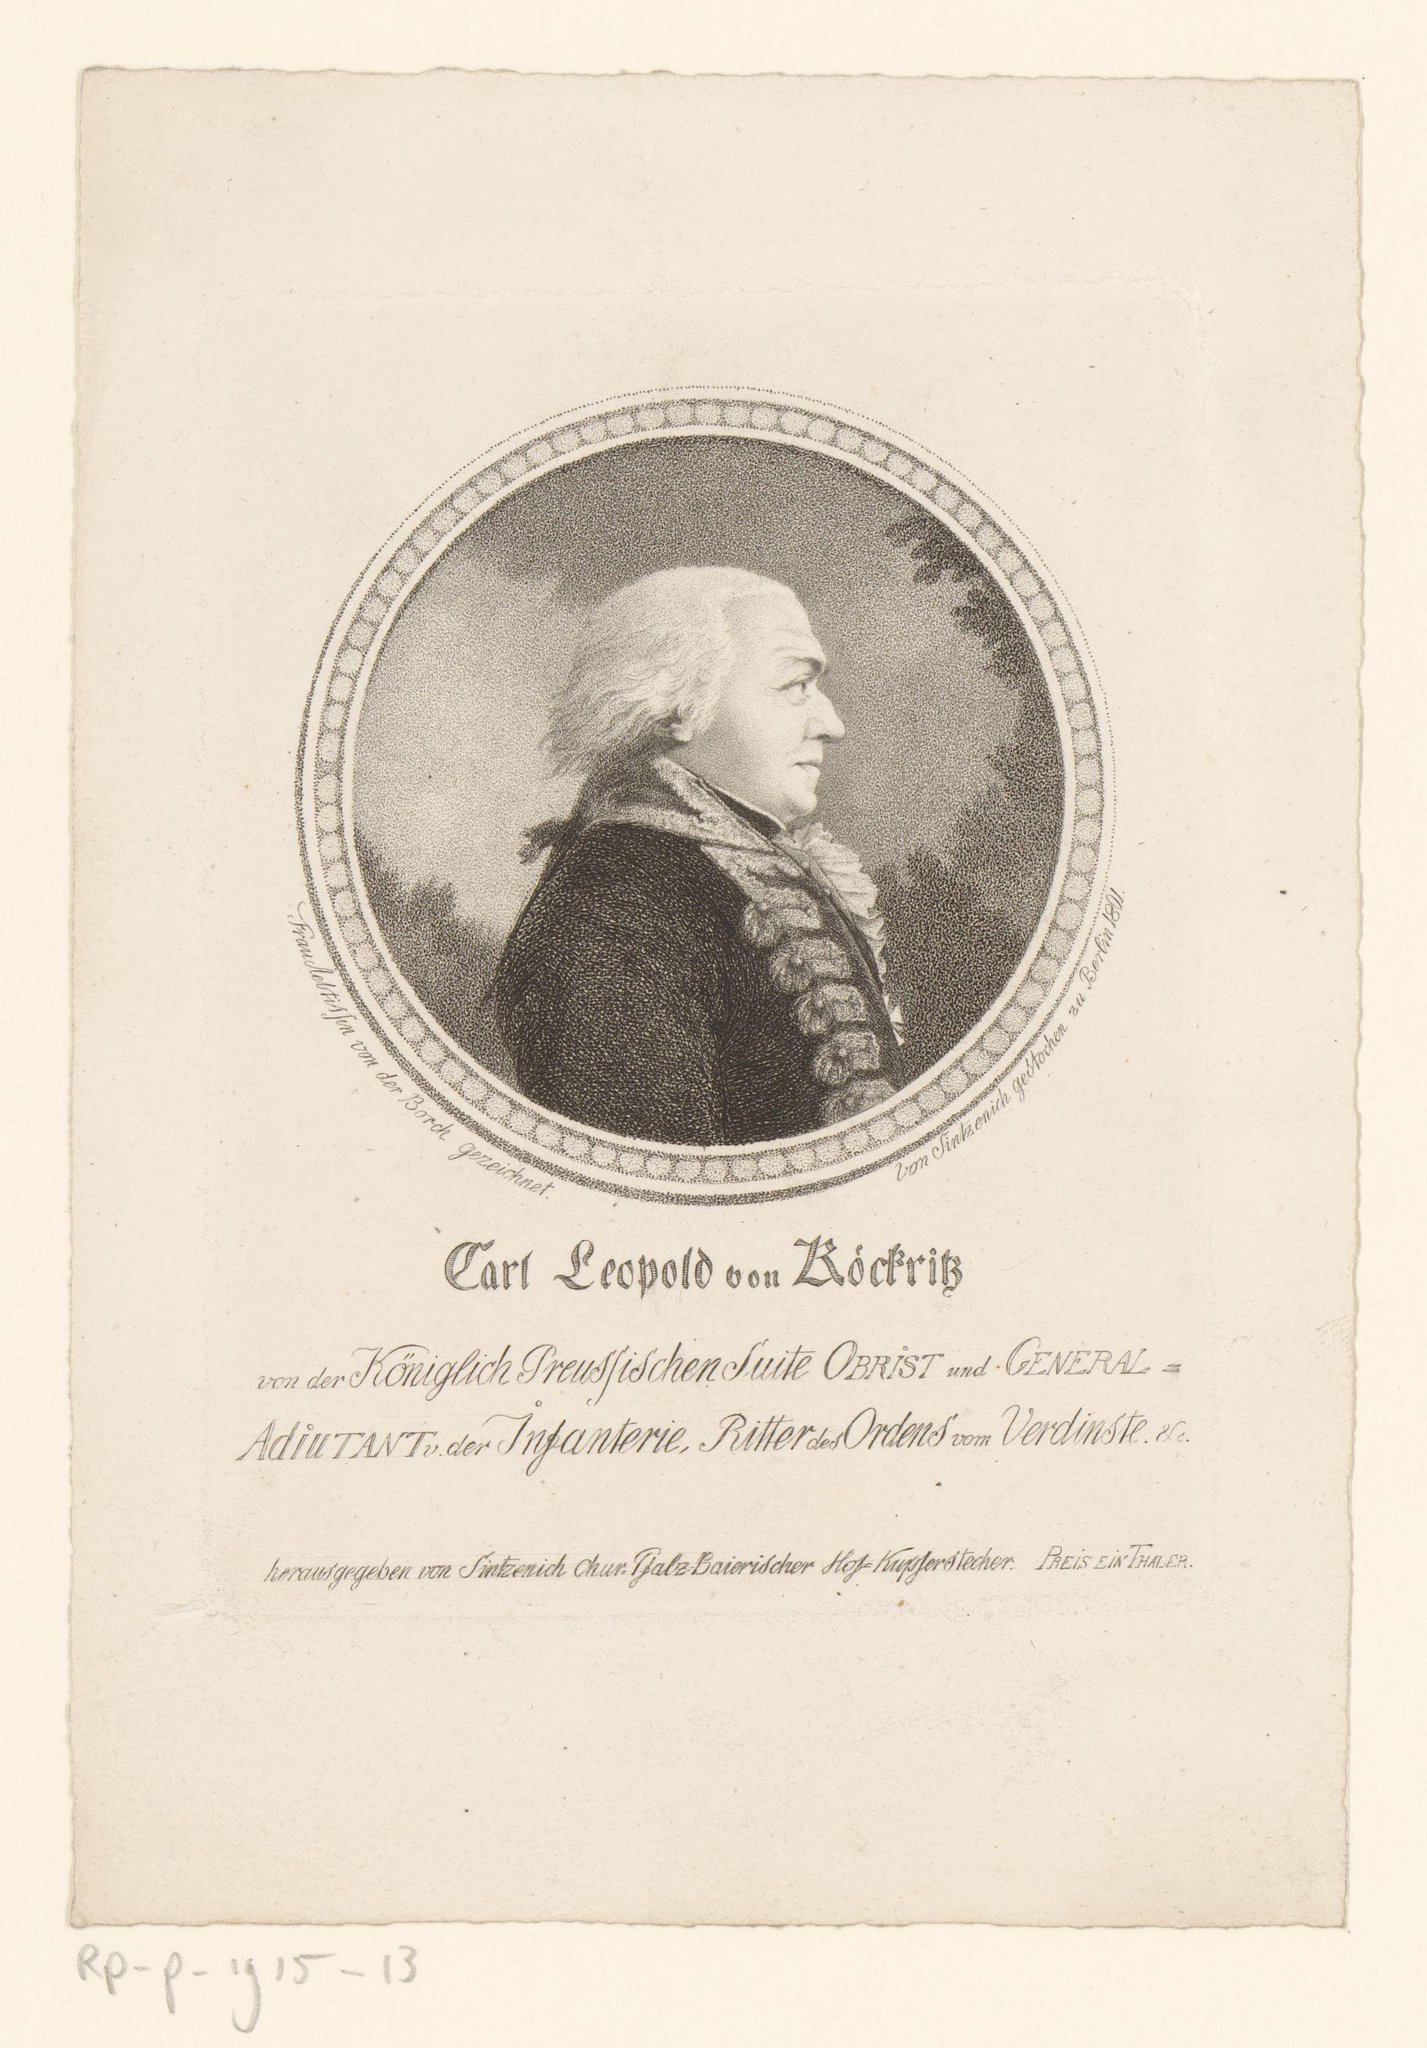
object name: print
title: Portret van Carl Leopold von Köckritz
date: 1801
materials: paper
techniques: engraving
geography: berlin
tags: historical persons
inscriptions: collector's mark: Lugt 2228